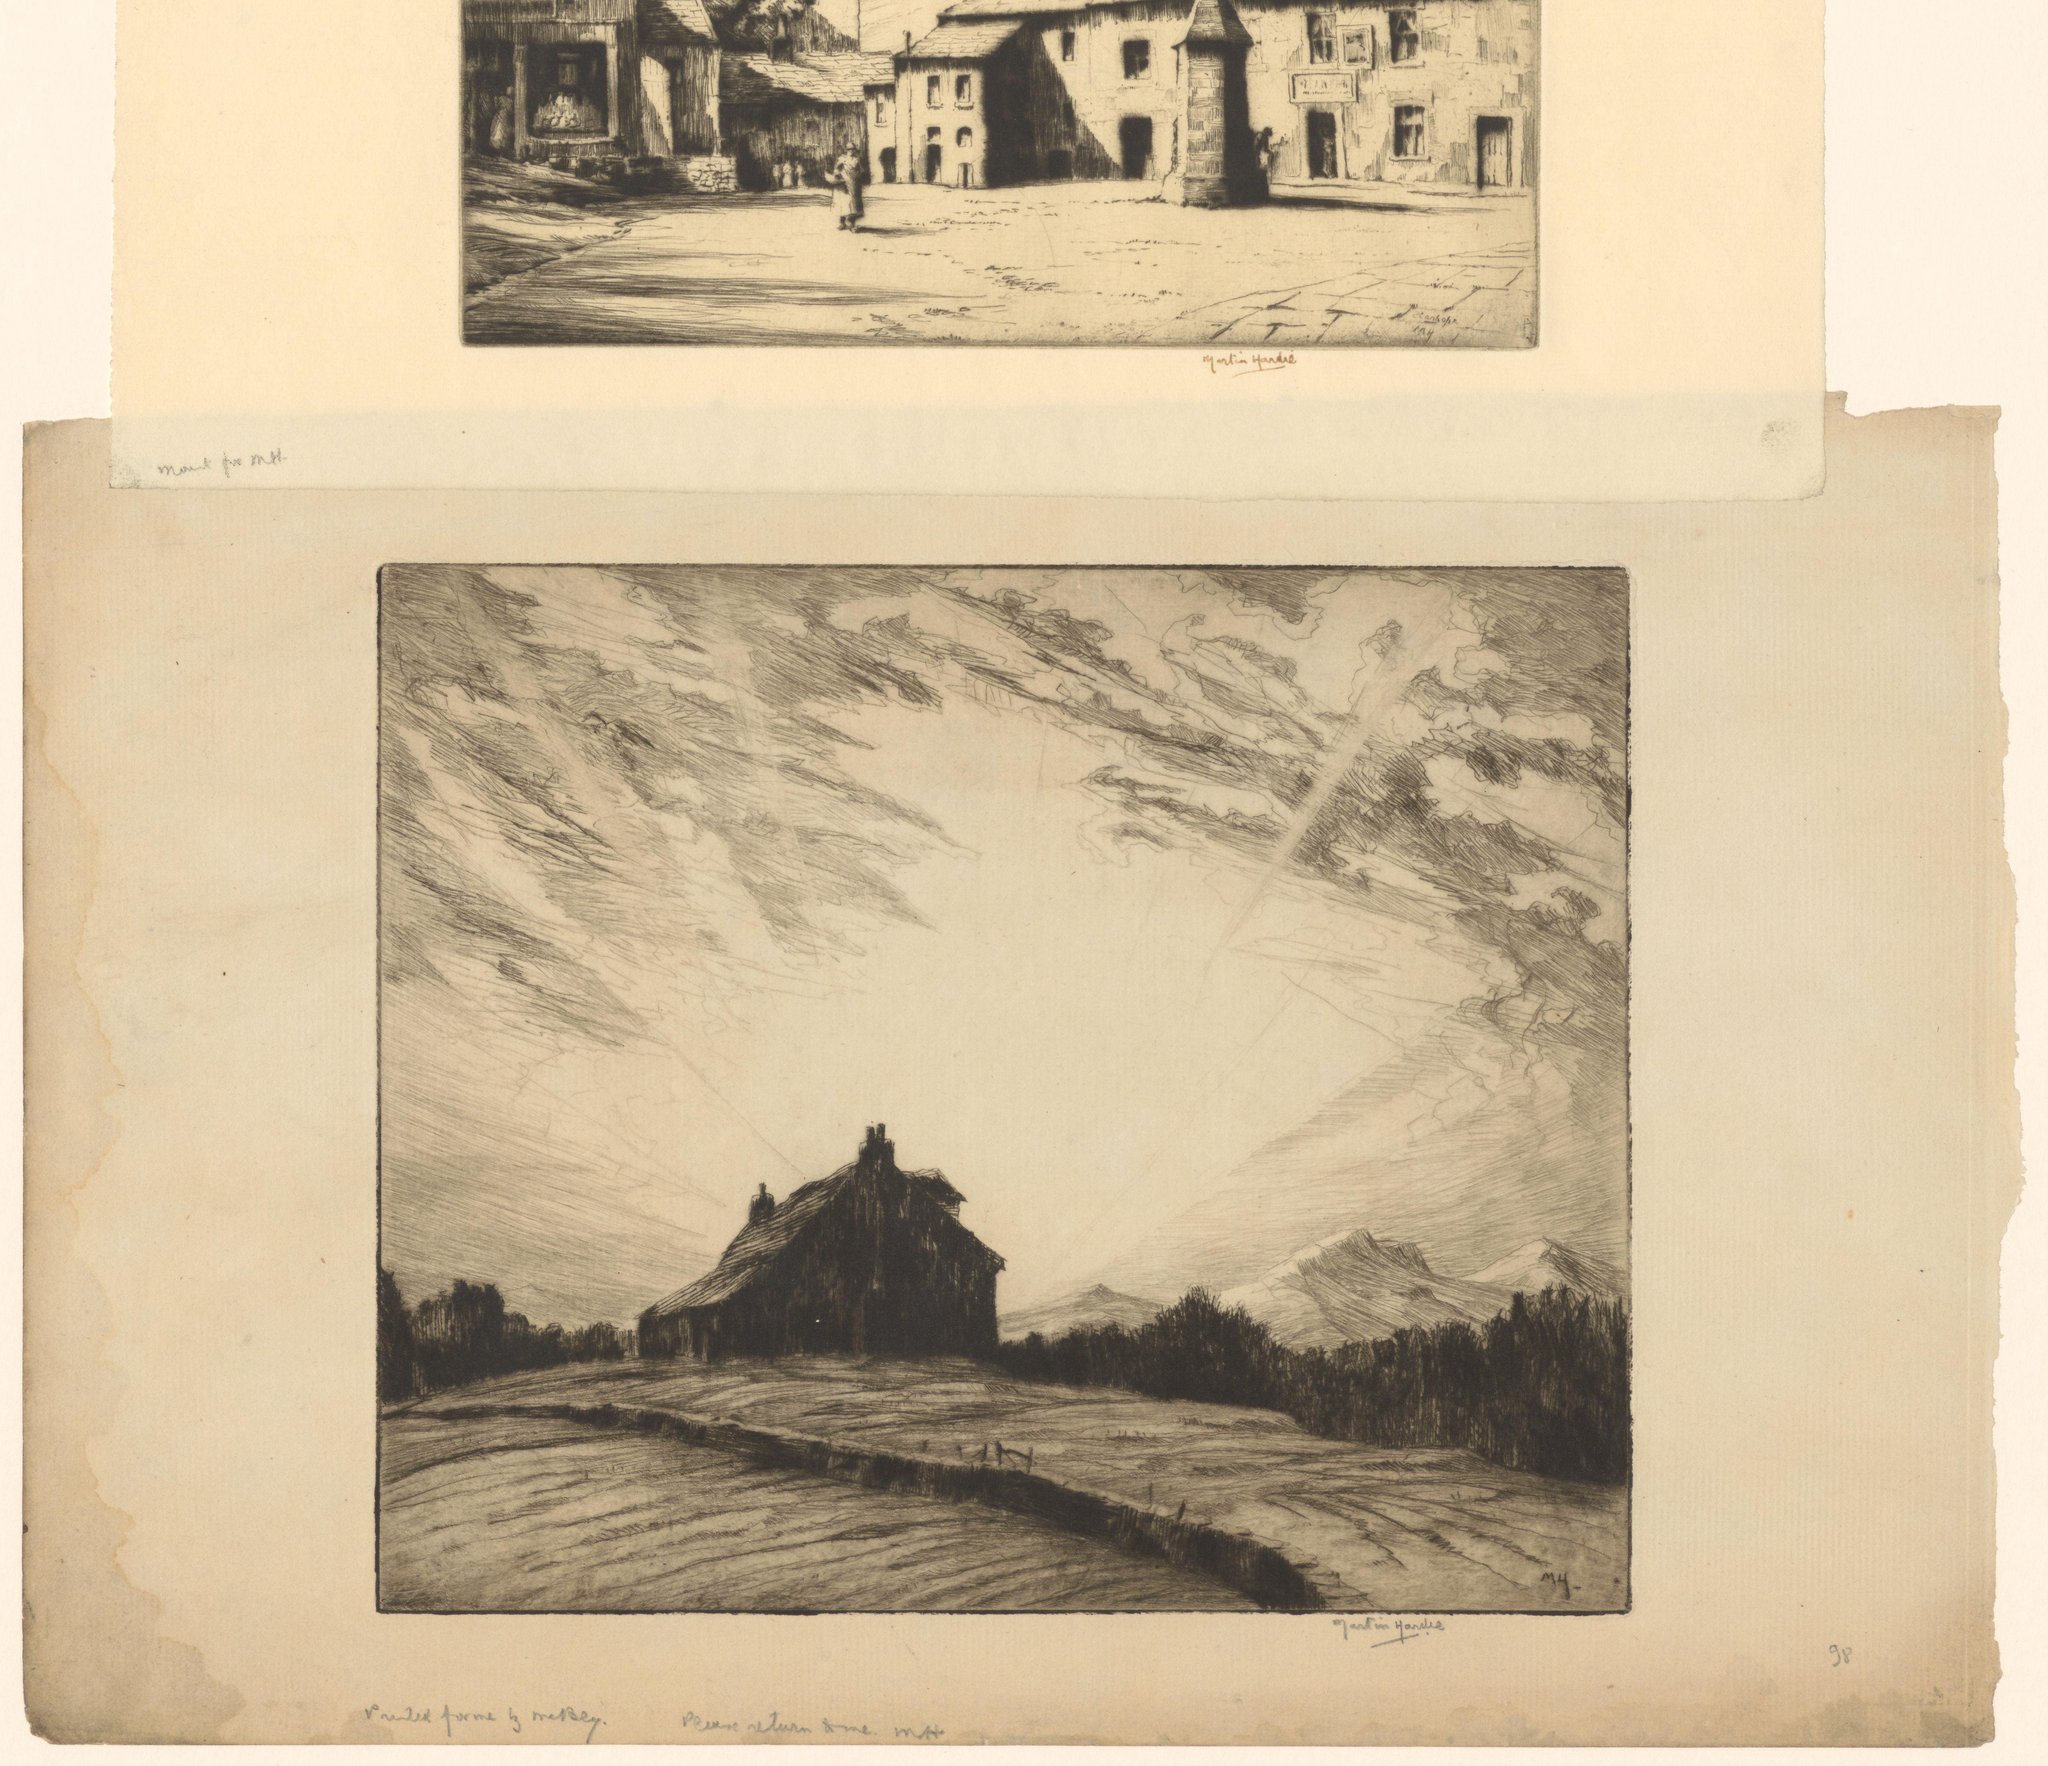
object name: print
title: Zonsondergang bij Blairgowrie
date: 1923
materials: paper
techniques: drypoint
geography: blairgowrie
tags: low hill country, sunset, farm or solitary house in landscape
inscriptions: collector's mark: Lugt 2760, annotation: ‘Martin Hardie’, collector's mark: Lugt 2228